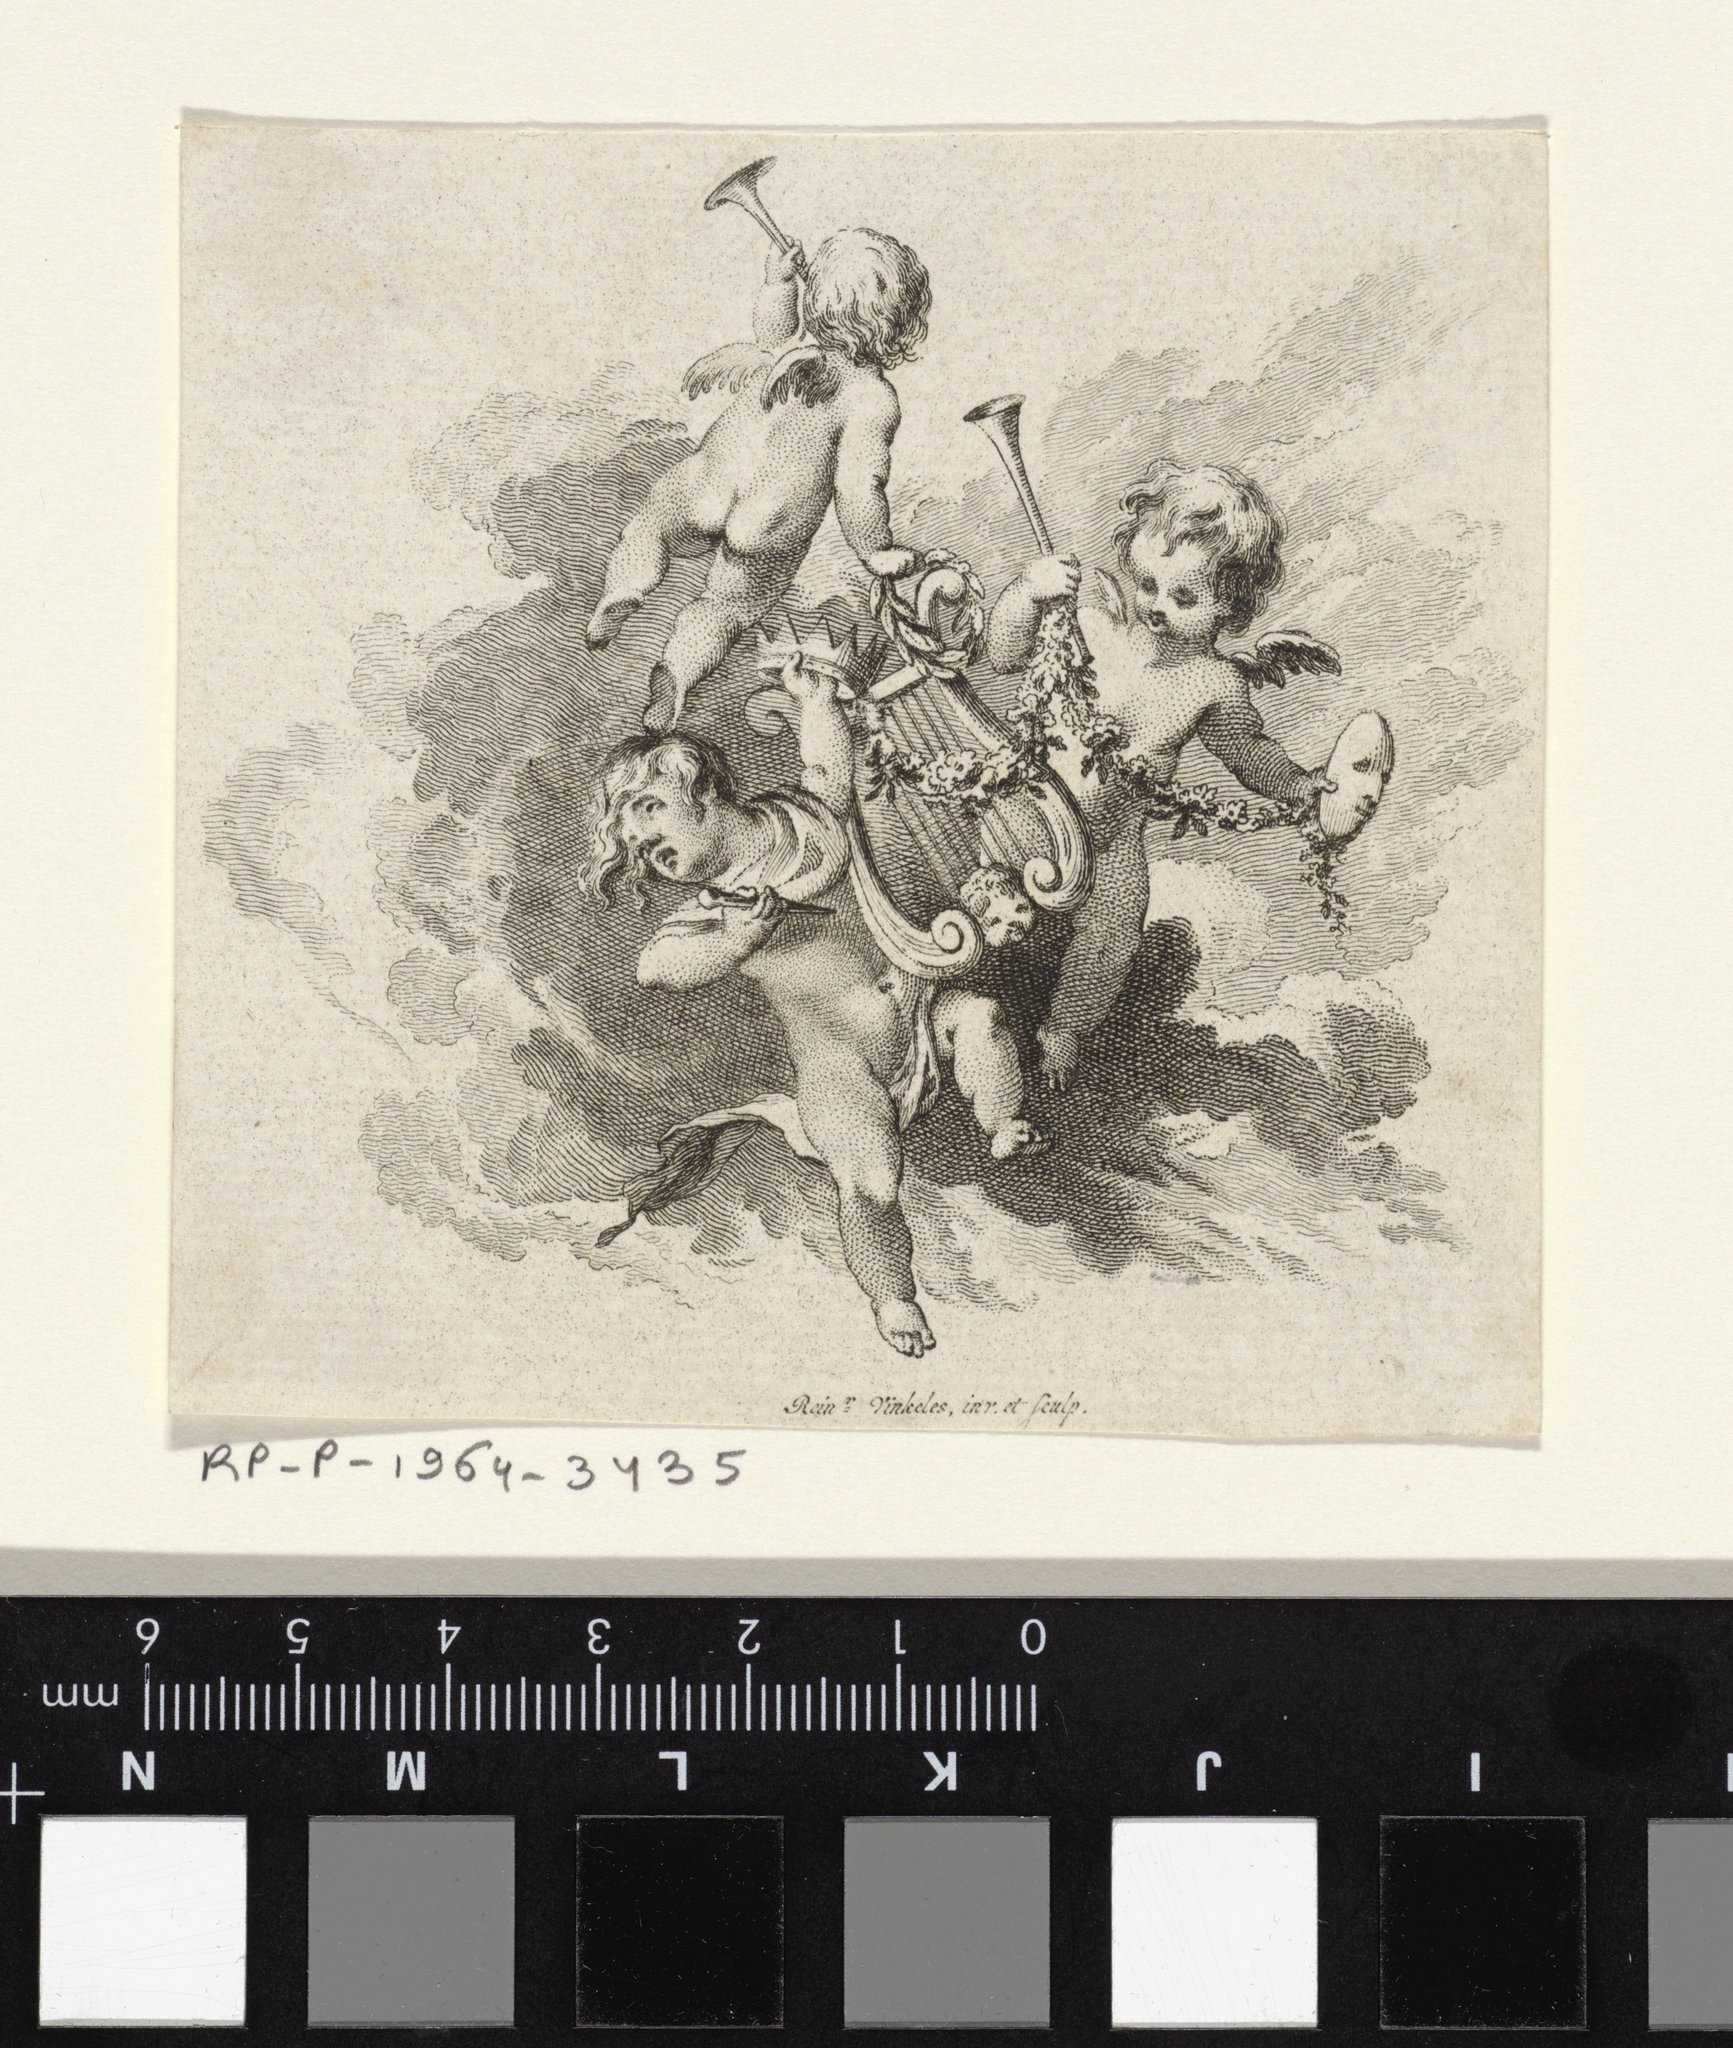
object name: print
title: Vignet met drie putti met bazuinen en een harp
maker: reinier vinkeles (i)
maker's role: draughtsman, print maker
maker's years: 1741-1816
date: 1751-1816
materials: paper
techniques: engraving, etching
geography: amsterdam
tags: mask, crown (symbol of sovereignty), horn, trumpet, cornet, trombone, tuba, cupids: 'amores', 'amoretti', 'putti'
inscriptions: collector's mark: Lugt 2228